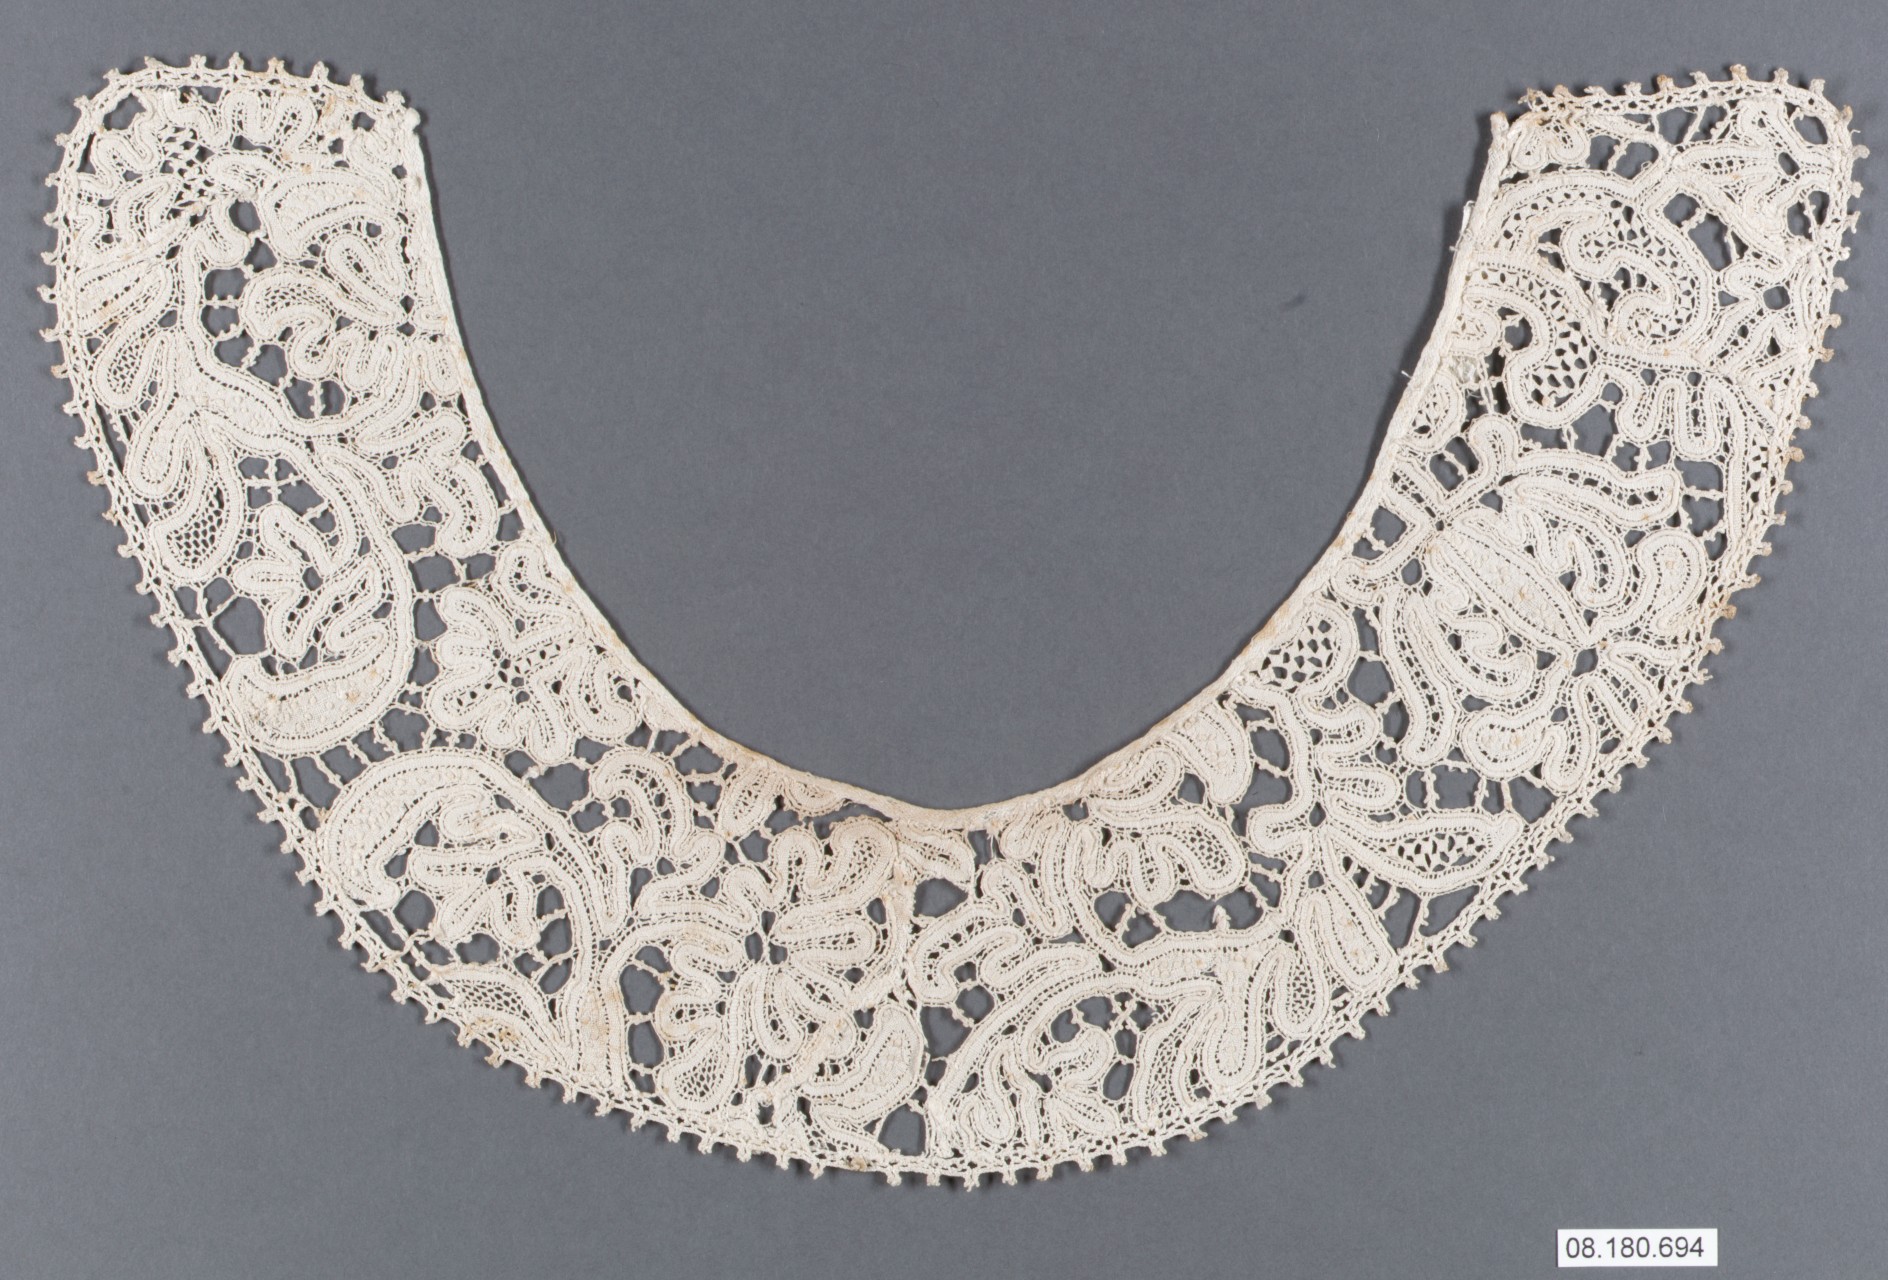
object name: collar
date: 1701-1800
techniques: lace